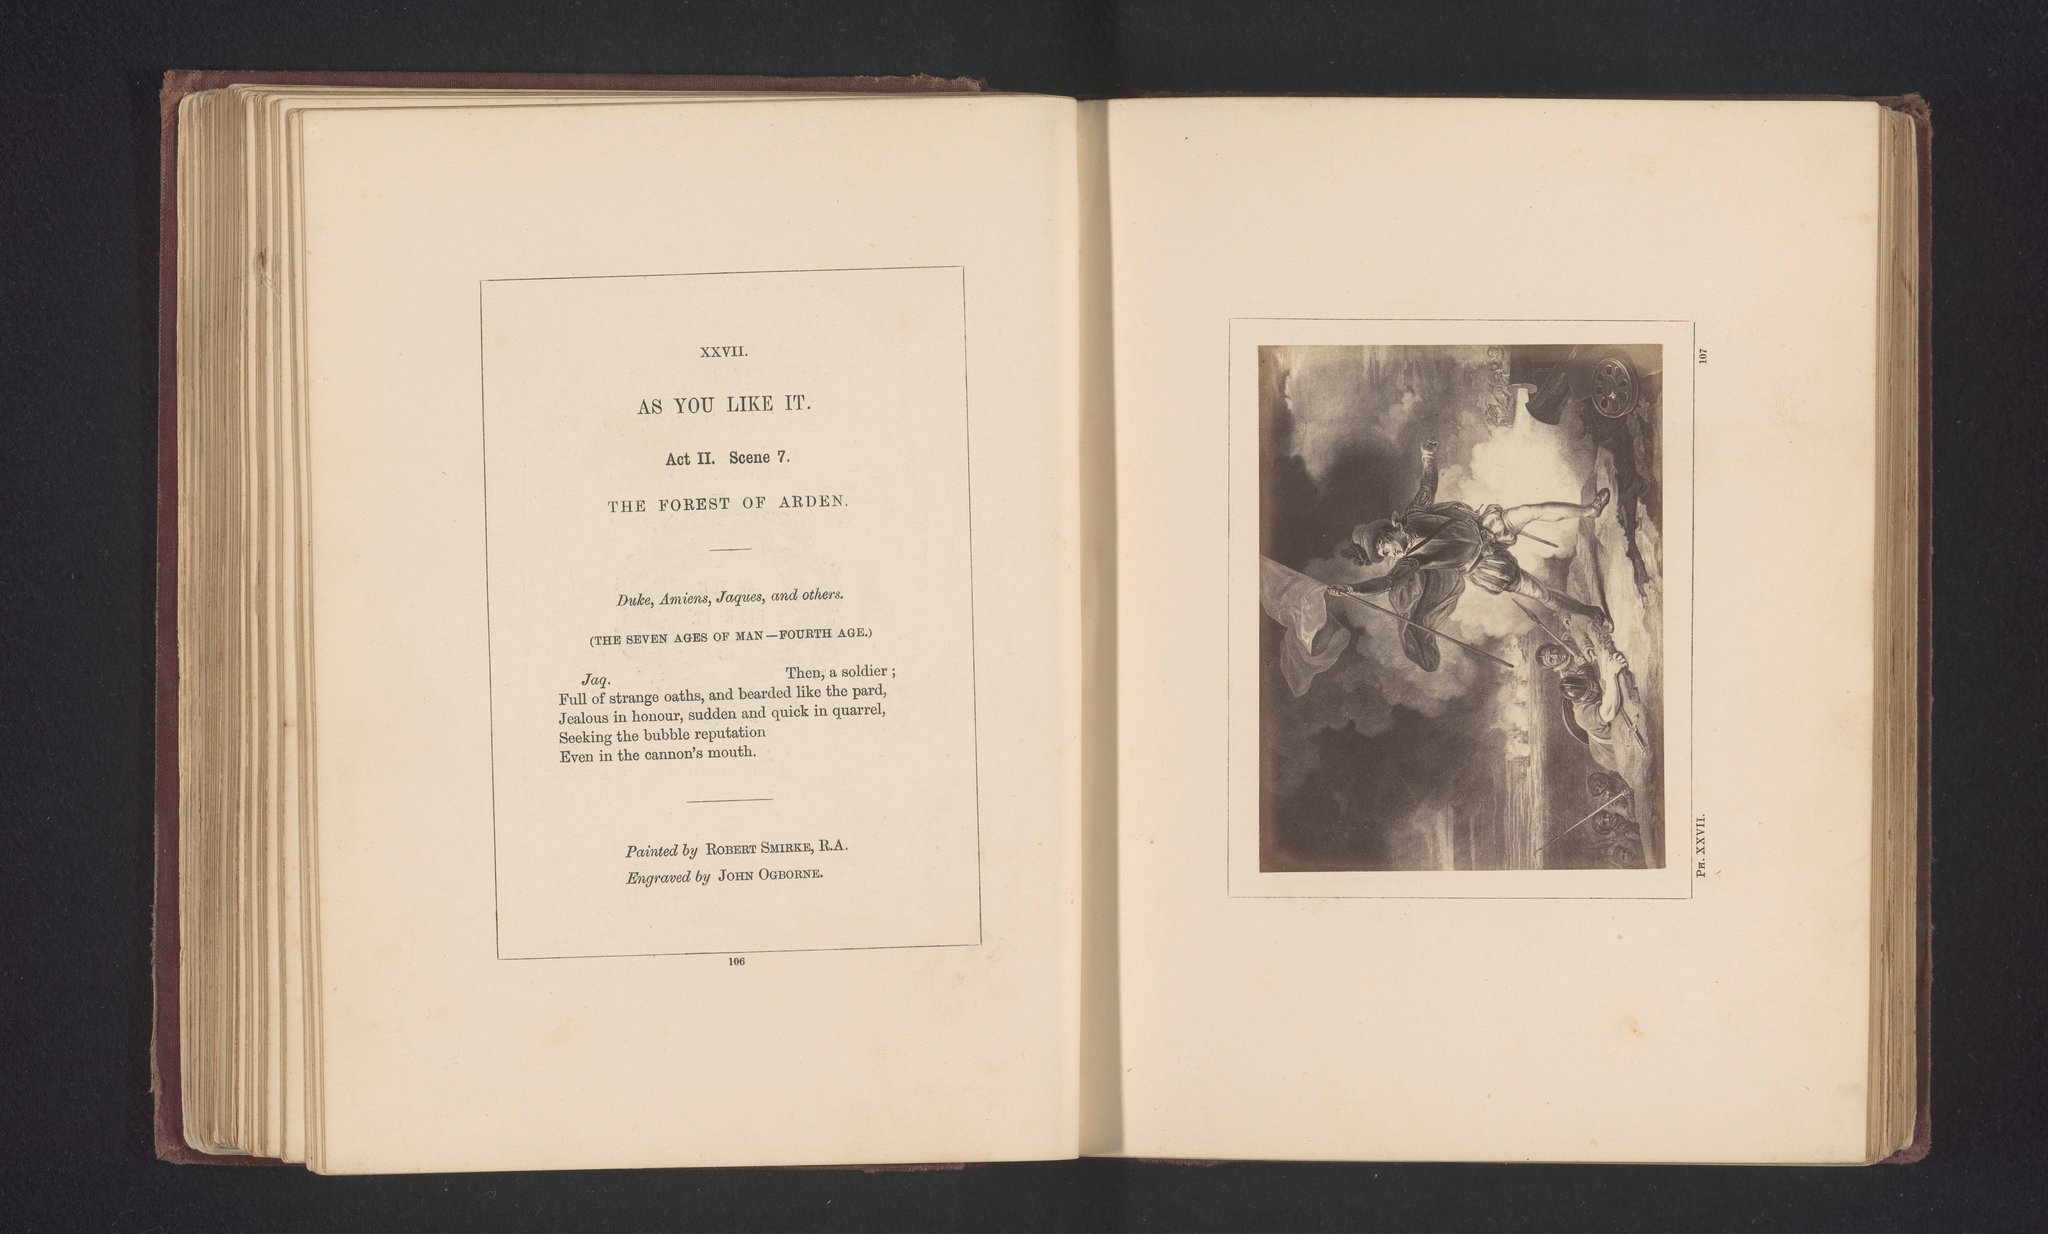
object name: photograph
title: Fotoreproductie van een prent naar een schilderij door Robert Smirke, voorstellend een scene uit Naar het u bevalt door William Shakespeare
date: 1854-1867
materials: photographic support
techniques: albumen print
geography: london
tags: specific works of literature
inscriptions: number: ‘Ph. XXVII. 107’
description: Te zien is een verbeelding van akte II, scene 7; Seven Ages Of Man.